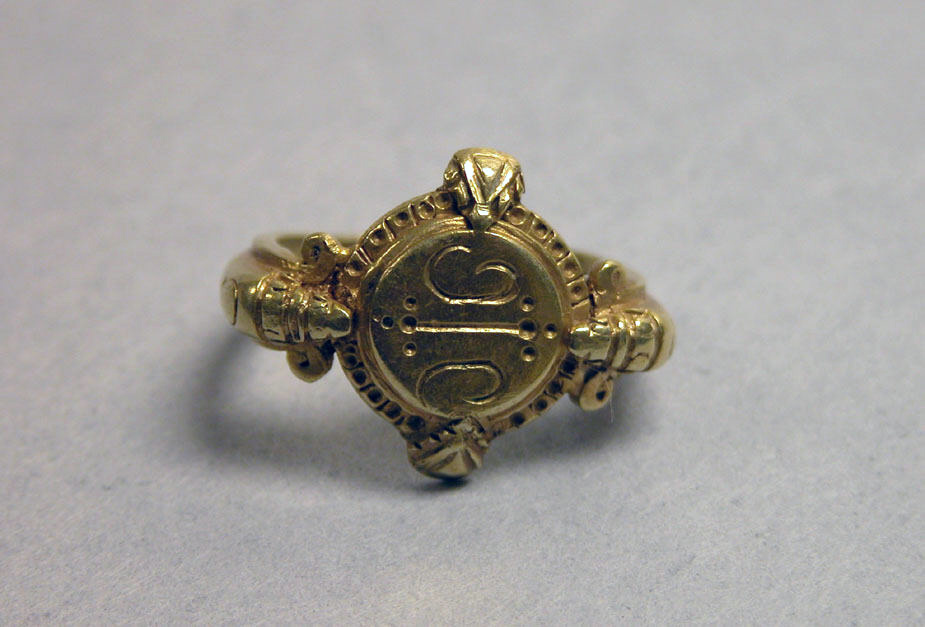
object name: ring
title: Stirrup-shaped Ring with Circular Bezel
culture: indonesian, javanese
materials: gold